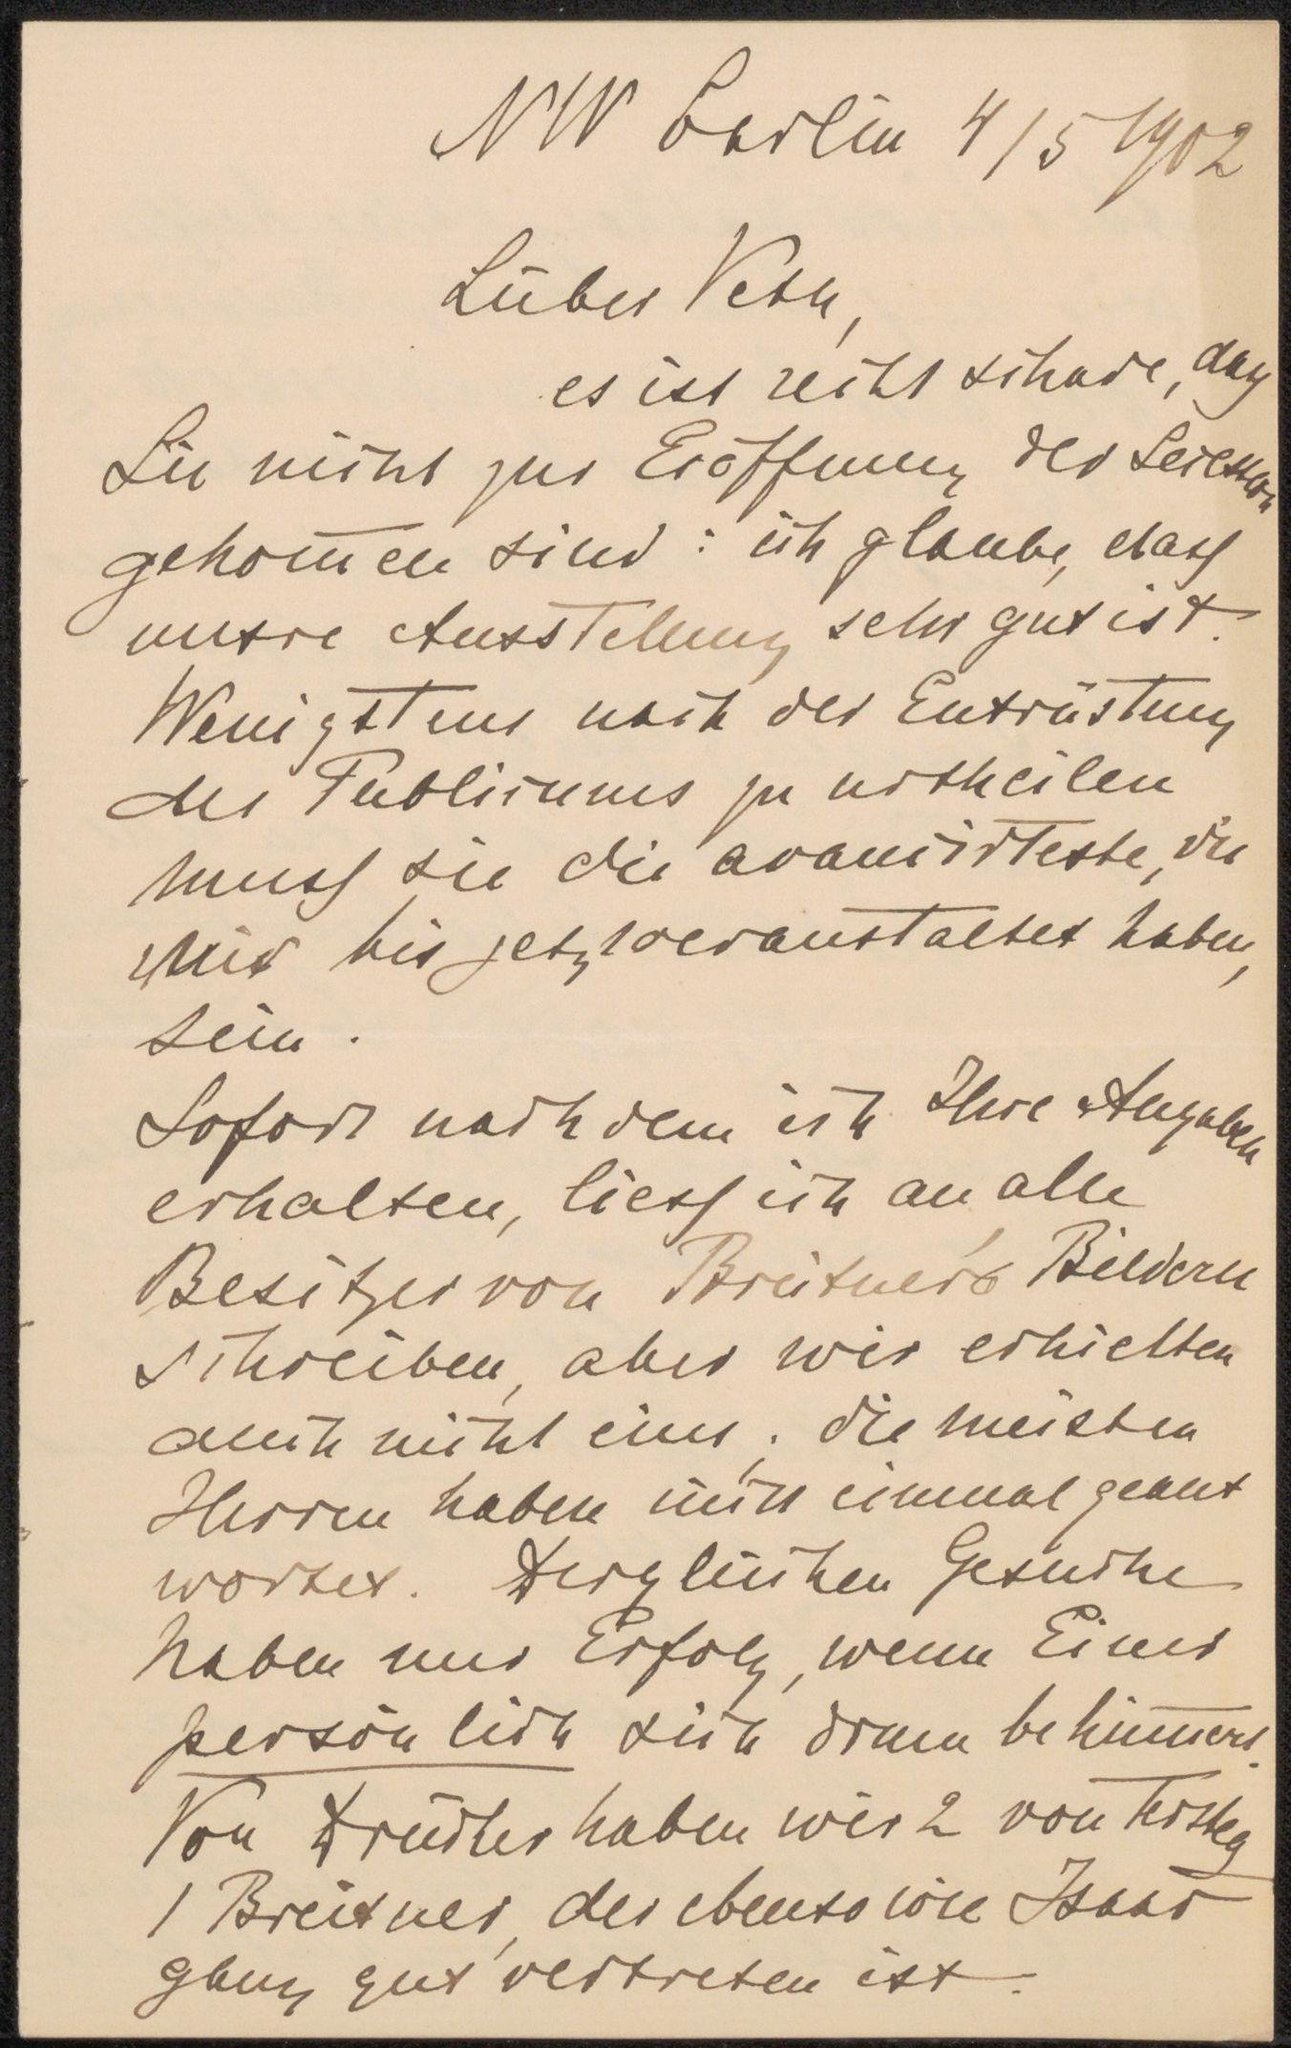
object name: letter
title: Brief aan Jan Veth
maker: max liebermann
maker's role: draughtsman, print maker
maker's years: 1847-1935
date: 1902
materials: ink, paper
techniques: pen, writing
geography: berlin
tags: painter, print maker, draughtsman, jozef israëls, rotterdam, amsterdam, george hendrik breitner, dordrecht, designer, jan veth, isaac israels, painting (including book-illumination, miniature-painting), exhibition ~ art, money, berlin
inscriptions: watermark, collector's mark: ‘RPK’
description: Opgenomen in: Ernst Braun, Max Liebermann: Briefe 1902-1906, Baden-Baden: Deutscher Wissenschafts-Verlag, 2013, Band 3, p. 48-49.